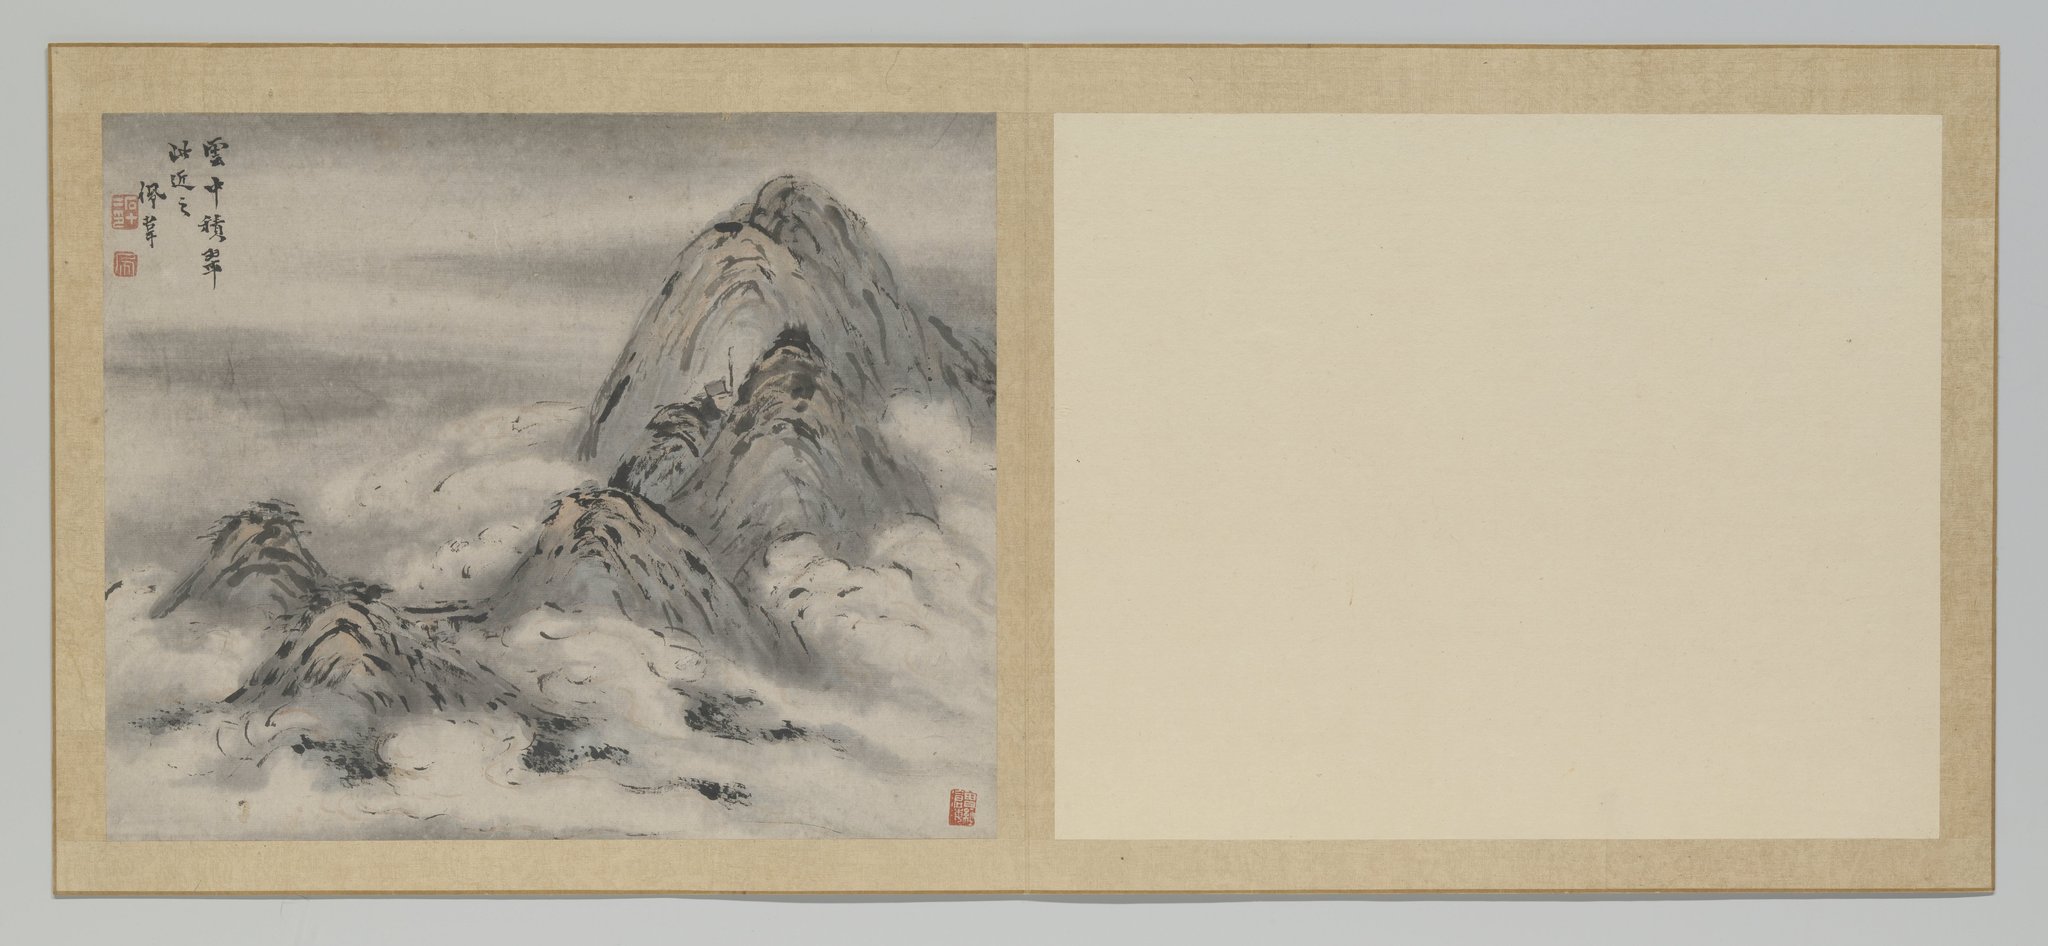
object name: painting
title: Schildering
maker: gao qipei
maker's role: painter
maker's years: 1661-1734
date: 1700-1750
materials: dye, ink, paper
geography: china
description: A mountain ridge in a sea of cloud. Gao Qipei (1660 - 1734). China, c. 1700. Colours and ink on paper. Gao Qipei painted many of the album leaves of landscape scenes from nature. As a high-placed official he held various positions which entailed travel. Every few years he left Peking to visit a different administrative district. During these journeys he sketched the landscape. Inscribed on the left is the text: 'Piles of emeraldgreen amidst the clouds / this is a fair approximation. Pei Wei.'